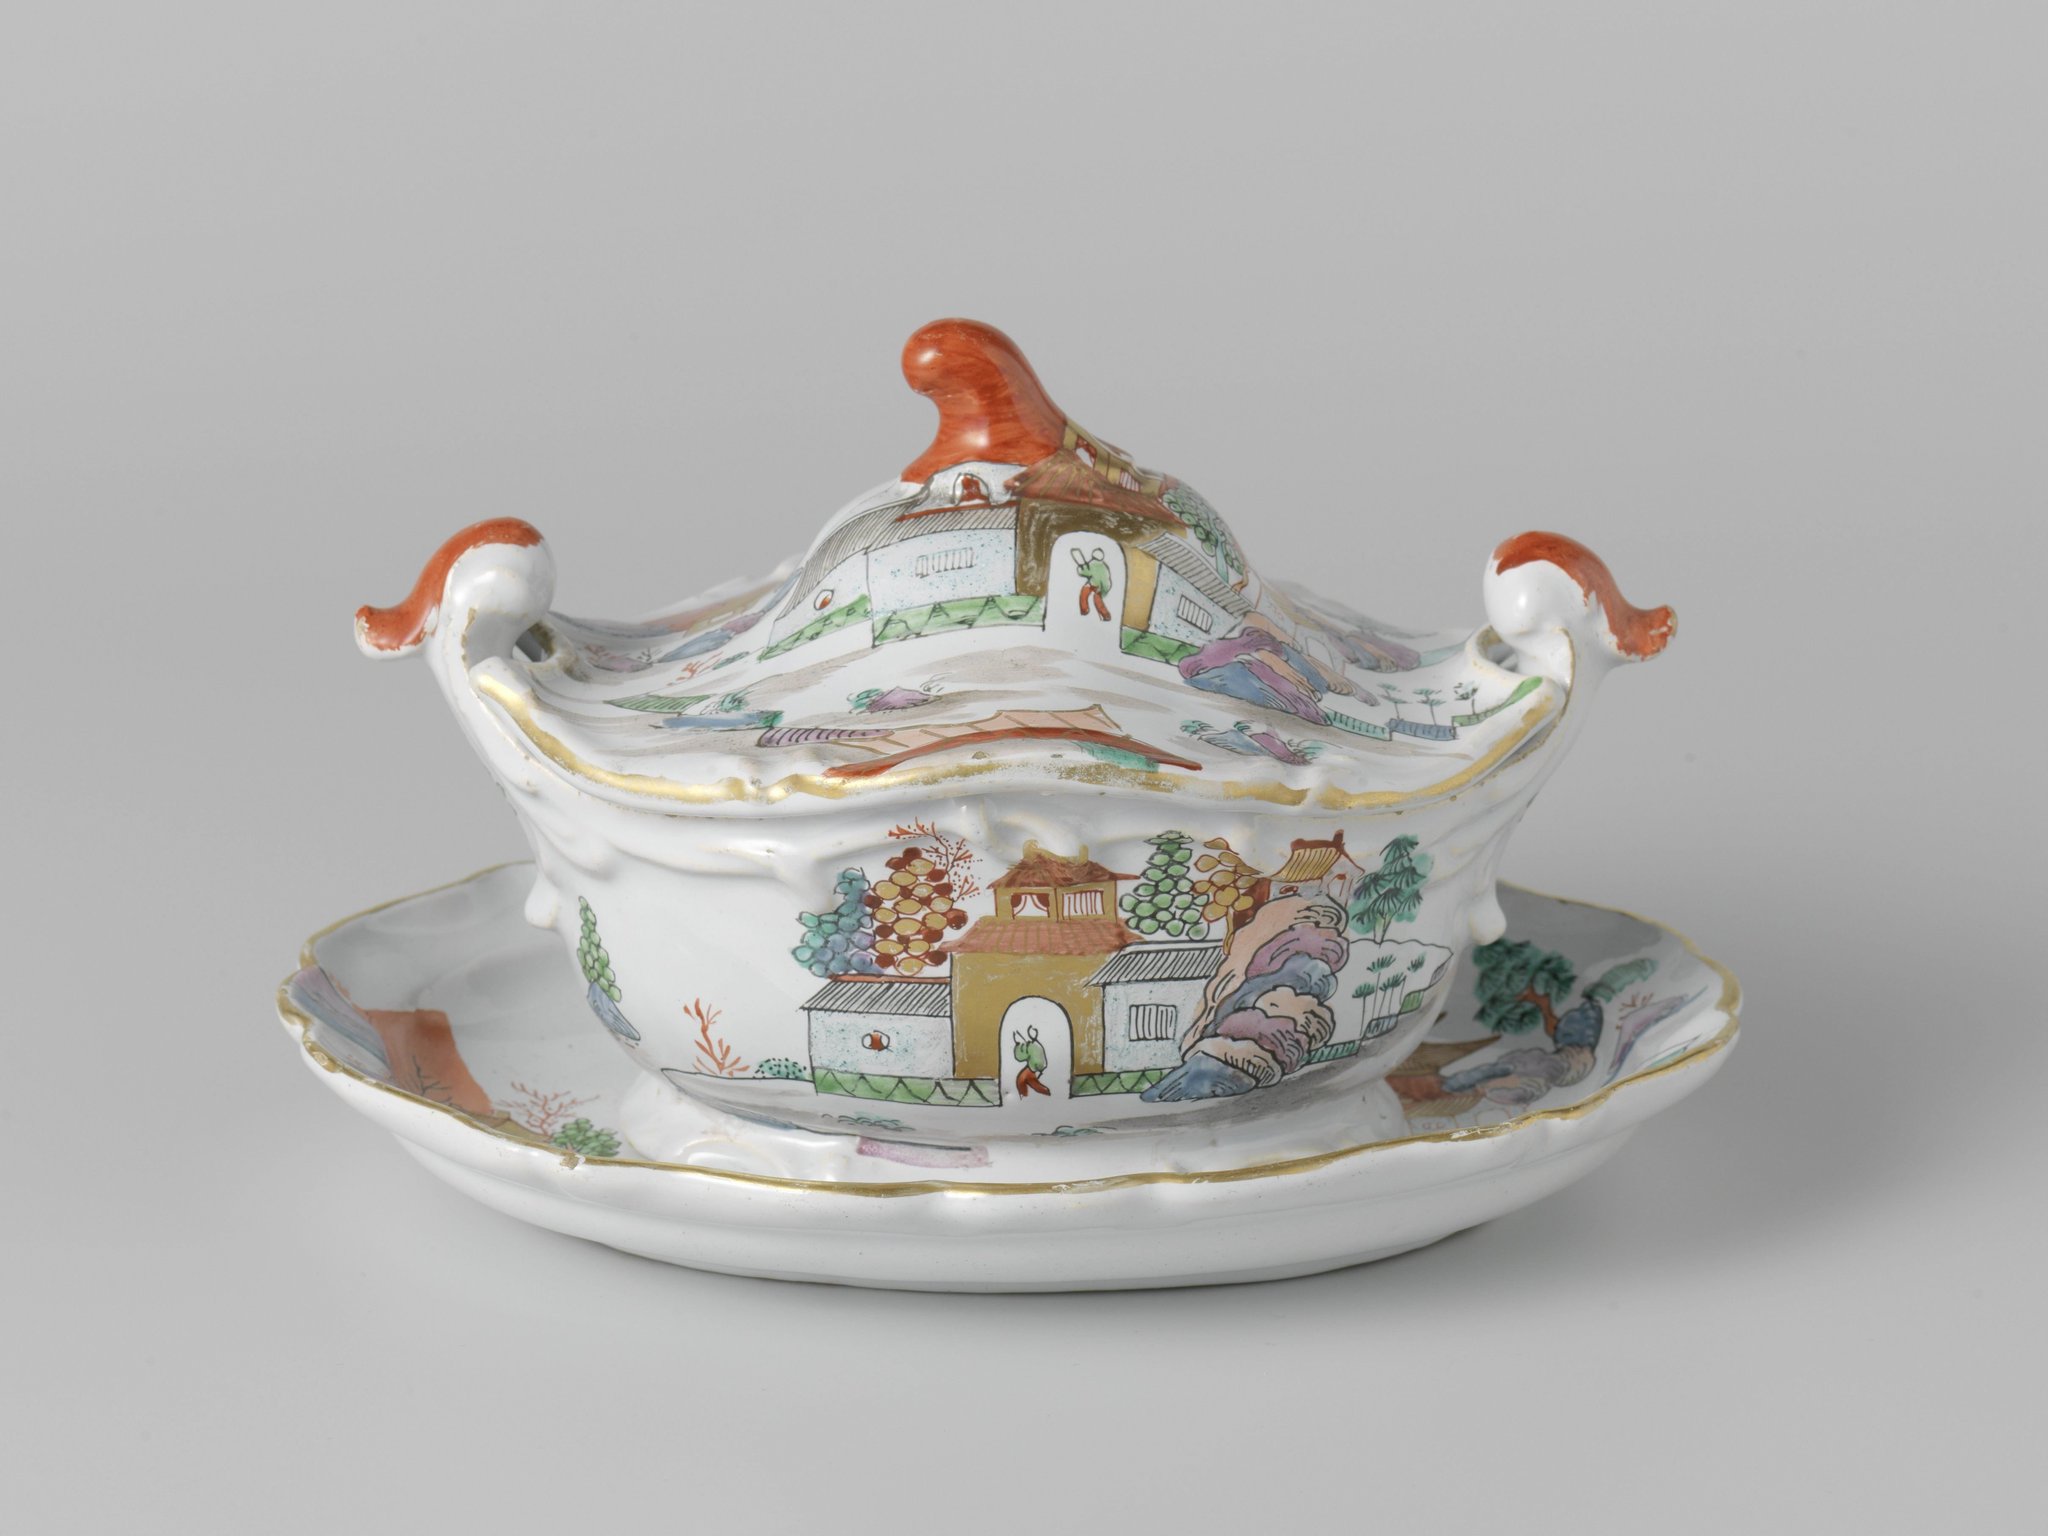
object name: butter dish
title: Butter dish and stand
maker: jacobus adriaens halder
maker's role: fayencier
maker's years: 1741-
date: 1765-1768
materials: earthenware, glaze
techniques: kiln, painted, polychromy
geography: delft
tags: chinese (+ other cultural aspects)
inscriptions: mark: ‘A/ IH’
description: Botervloot (C) met deksel (B) op onderschotel (A) veelkleurig versierd met een oosters landschap met rotsen en gebouwen. Gemerkt.